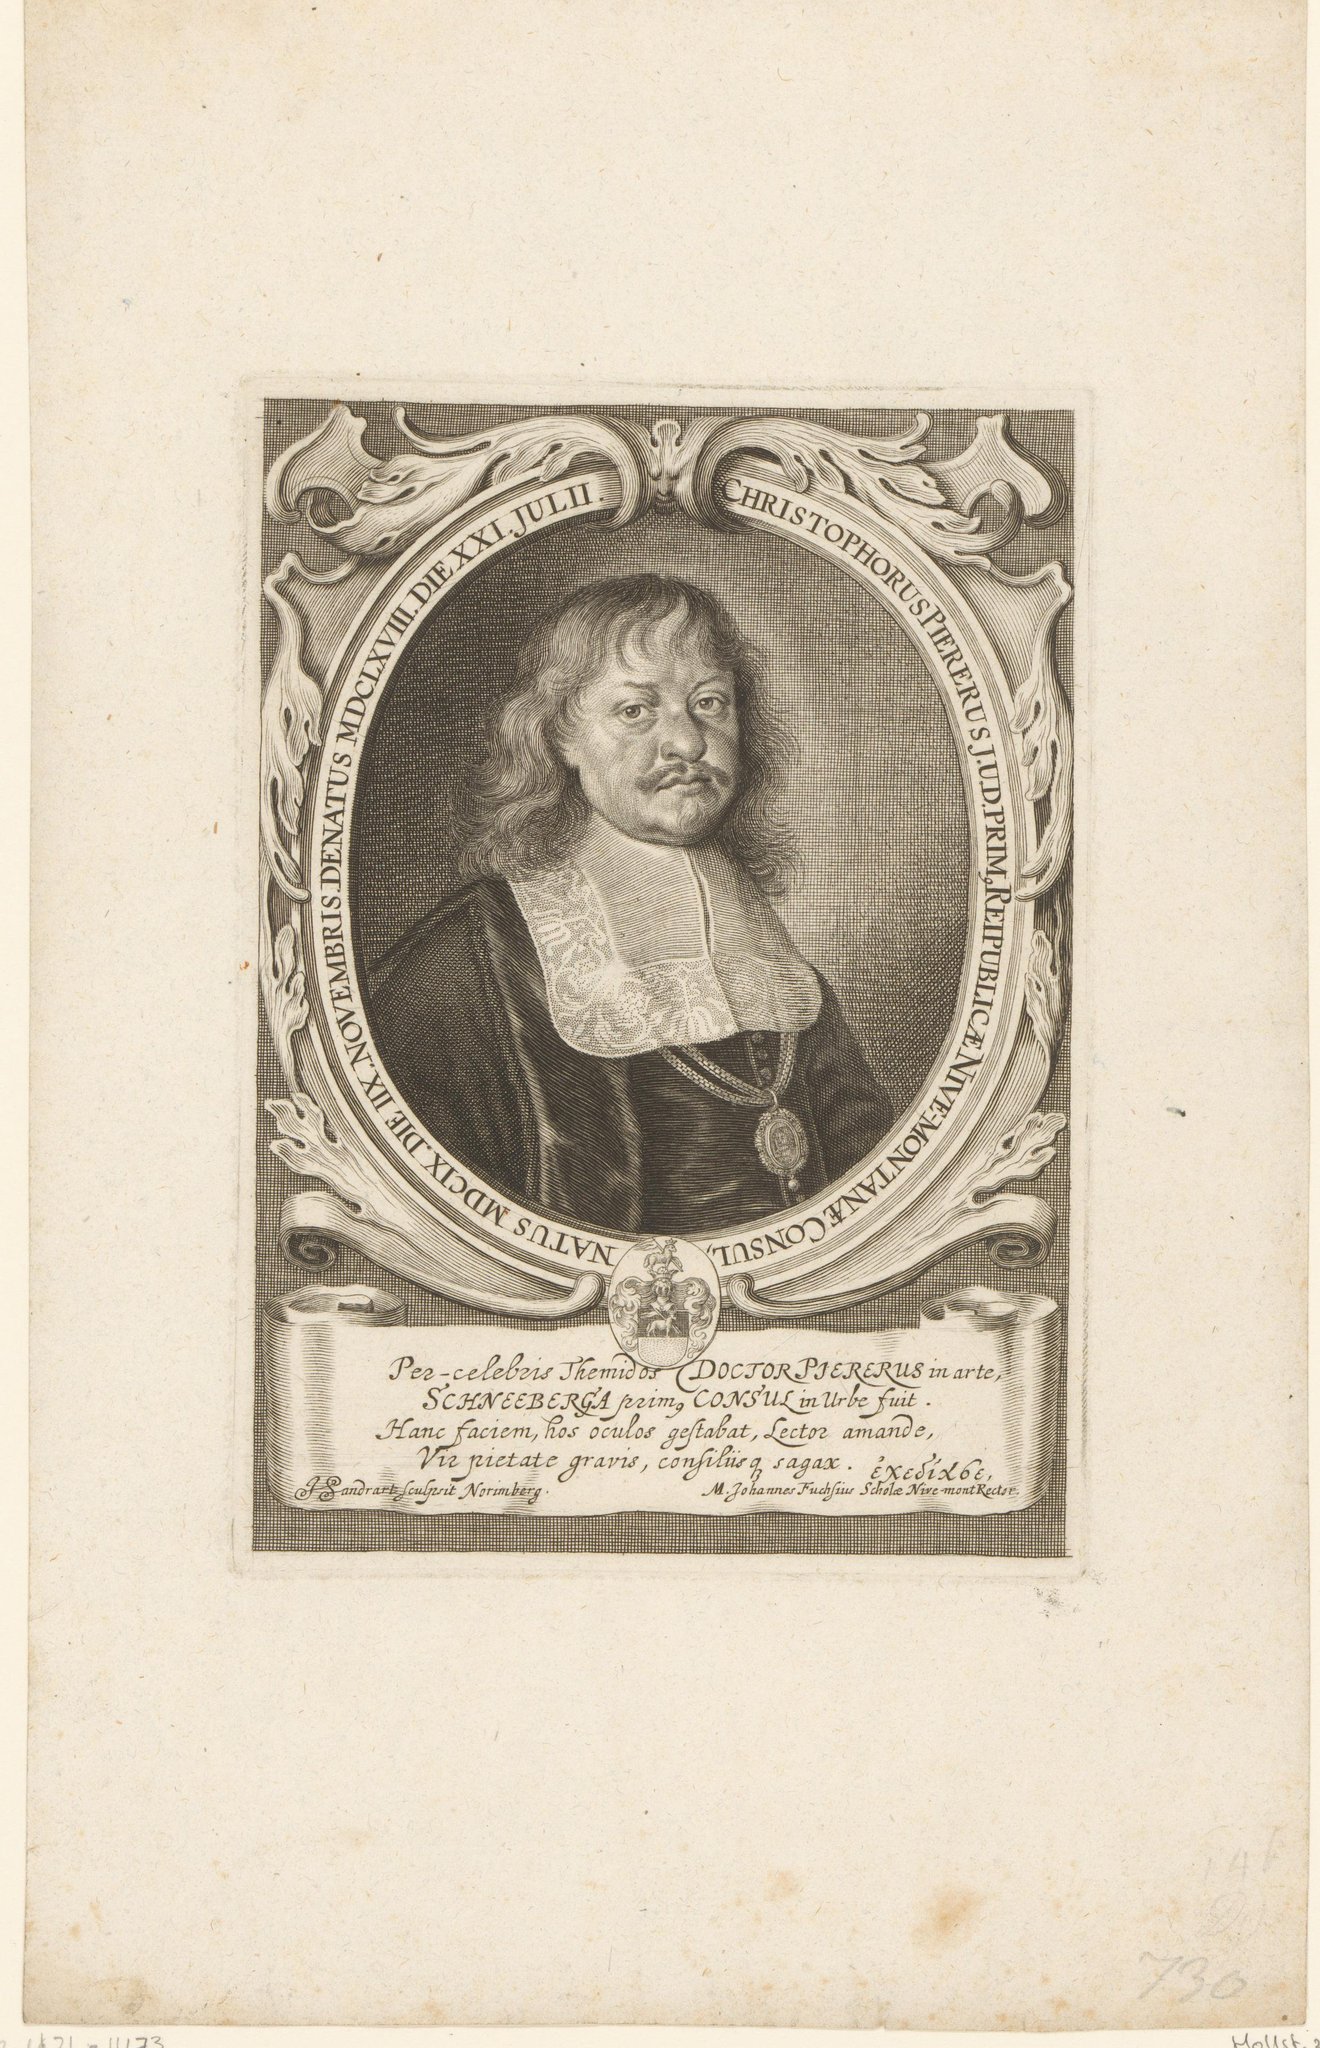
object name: print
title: Portret van Christoph Pierer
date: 1668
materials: paper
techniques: engraving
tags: mayor, historical persons, pendant, trinket, 'breloque', armorial bearing, heraldry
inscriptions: collector's mark: Lugt 2228